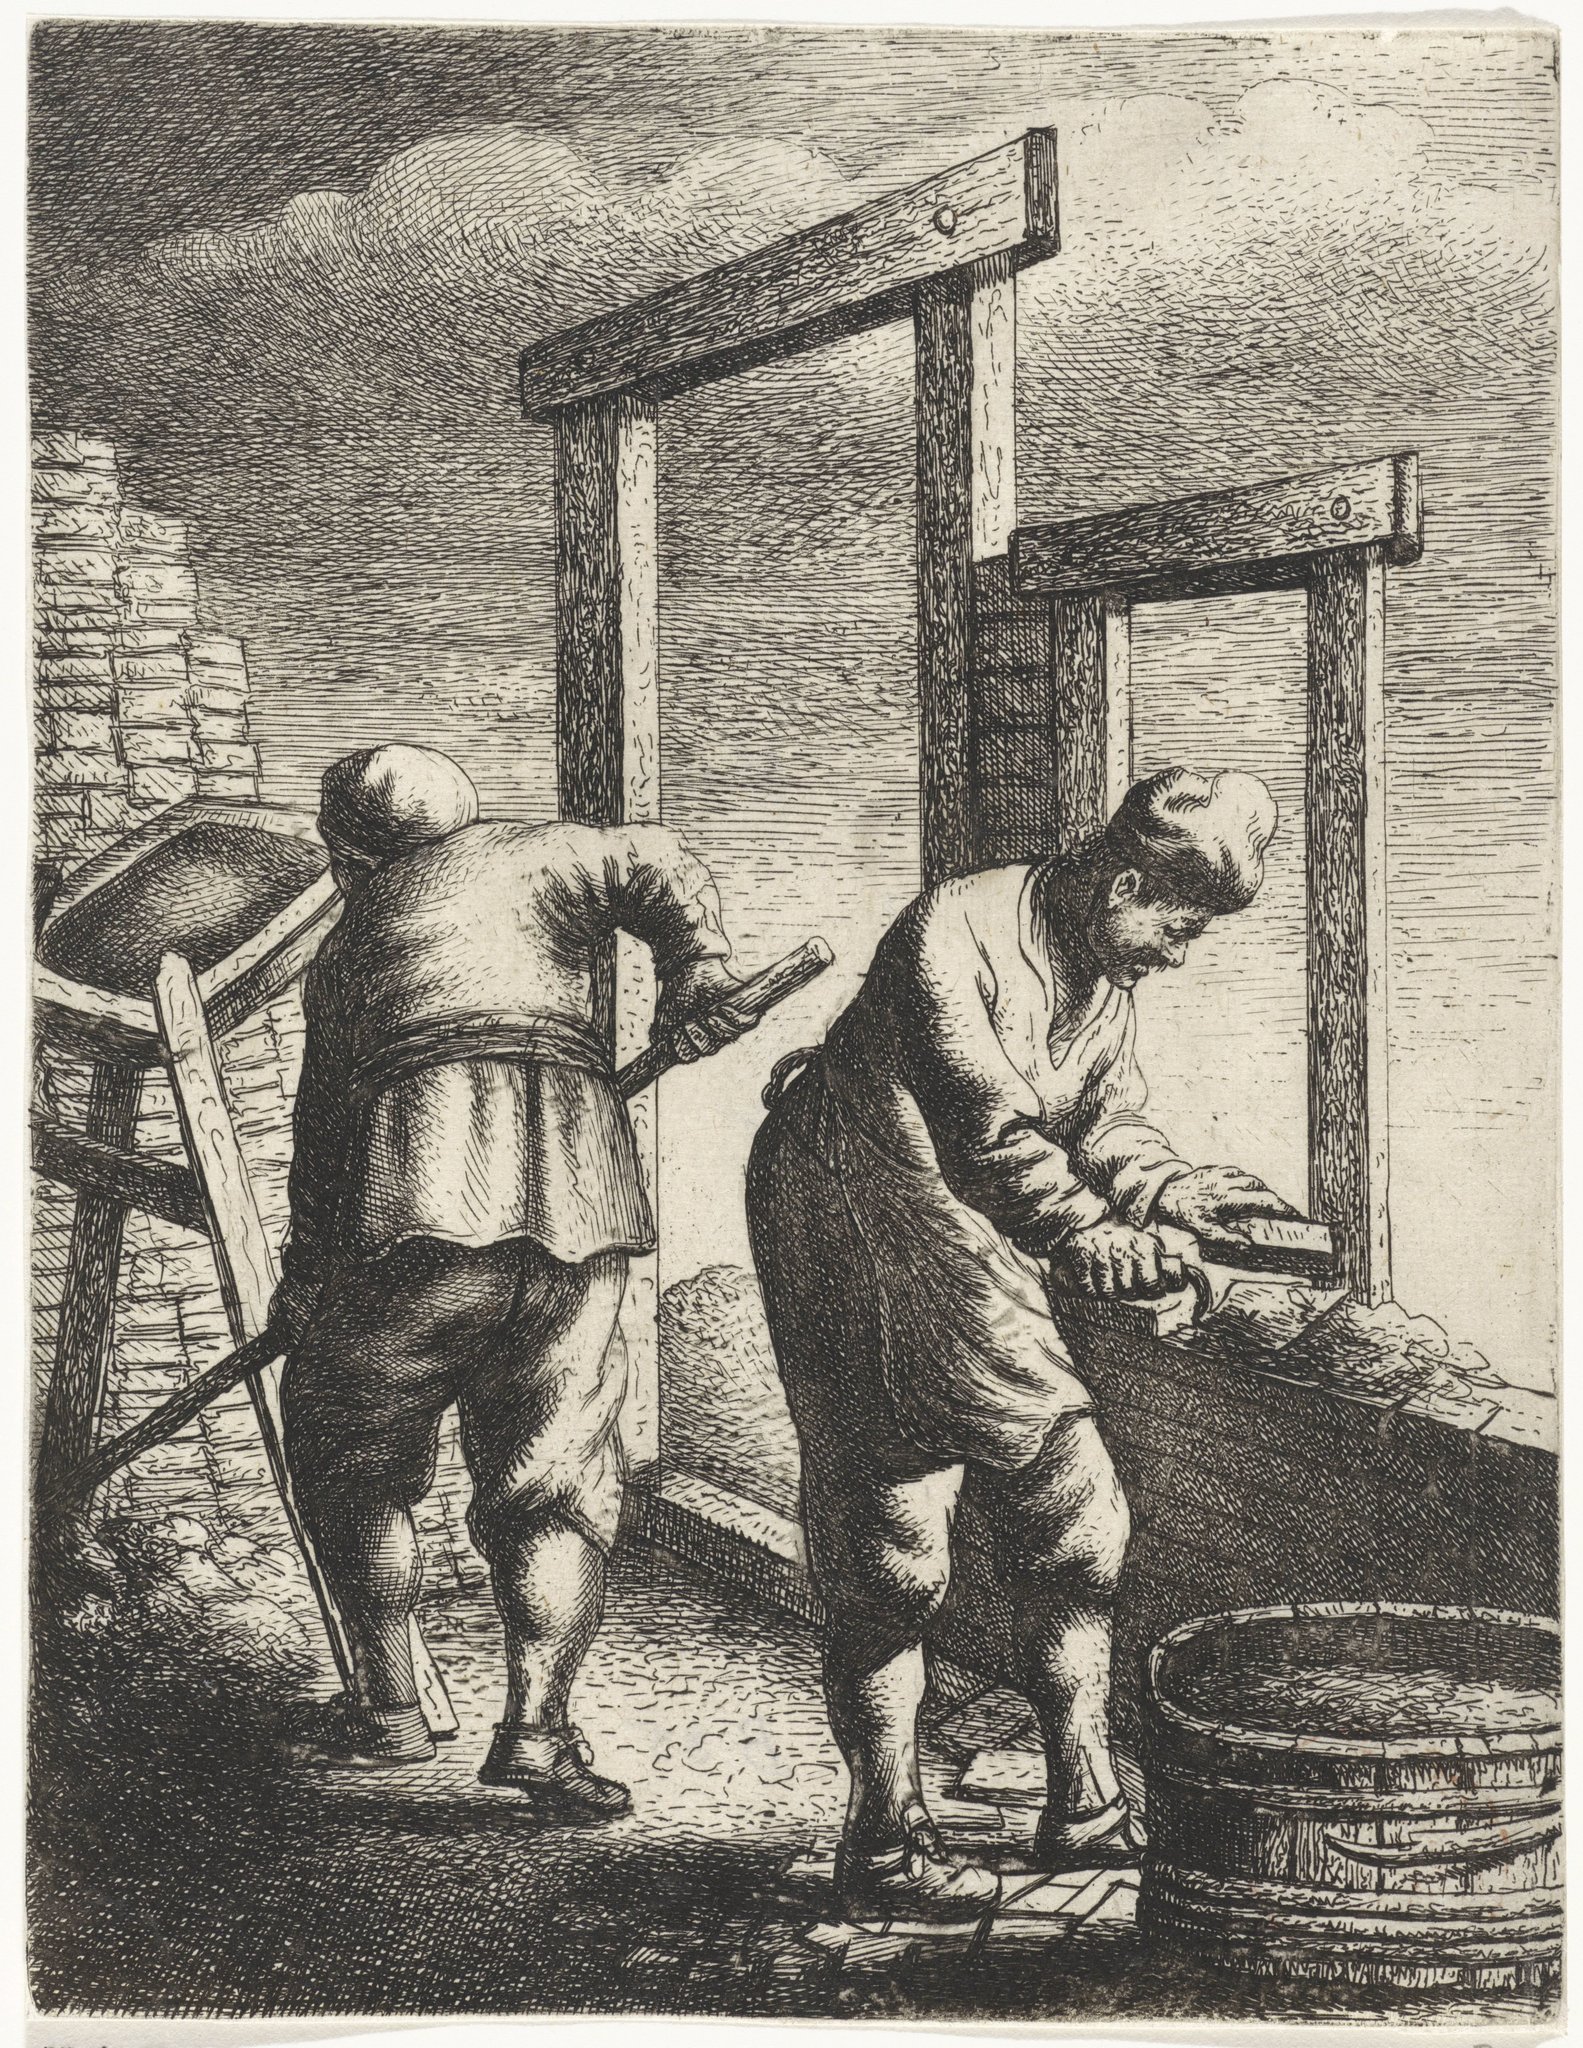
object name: print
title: Beroepen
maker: jan gillisz. van vliet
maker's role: draughtsman, painter, print maker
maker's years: 1600-1668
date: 1635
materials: paper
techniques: etching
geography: leiden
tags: making the carcass (~ building activities), clay and sand, etc. ~ building material, stone ~ building material, mason at work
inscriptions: collector's mark: Lugt 240